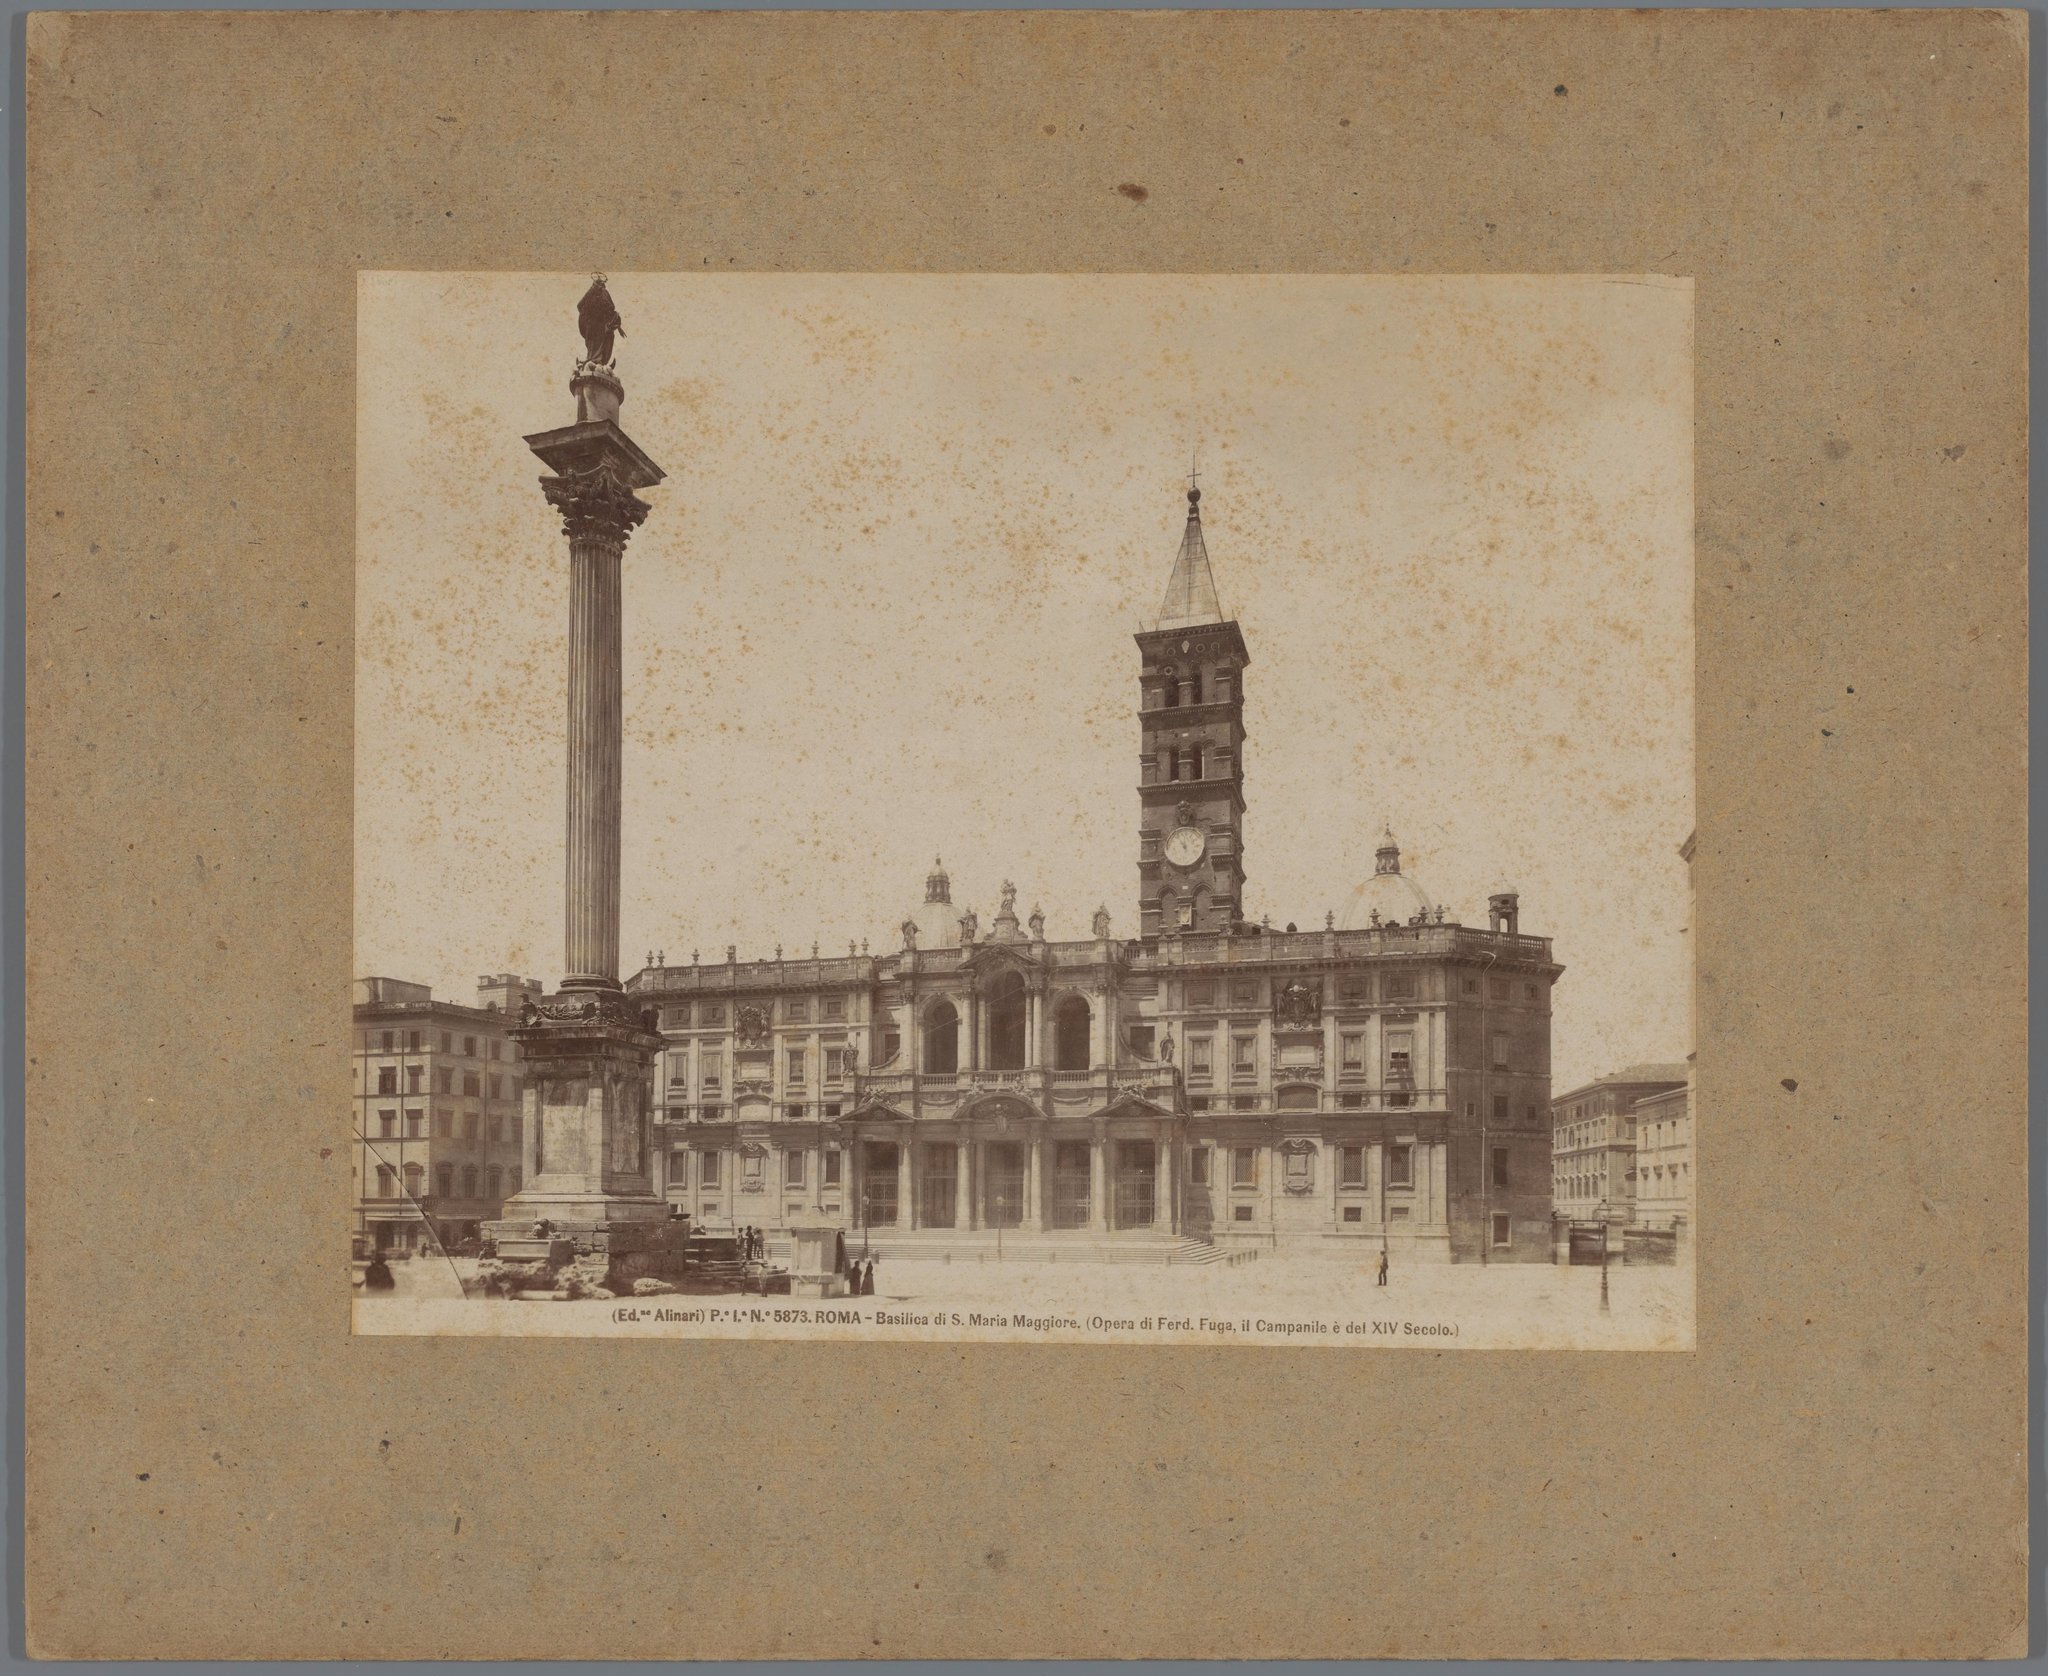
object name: photograph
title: Gezicht op de Santa Maria Maggiore te Rome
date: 1875-1900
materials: cardboard, photographic support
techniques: albumen print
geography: rome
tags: parts of church exterior and annexes: campanile, monument, statue (+ city(-scape) with figures, staffage), church (exterior)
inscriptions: number: ‘P.e I.a N.o 5873.’, collector's mark: Lugt 3937